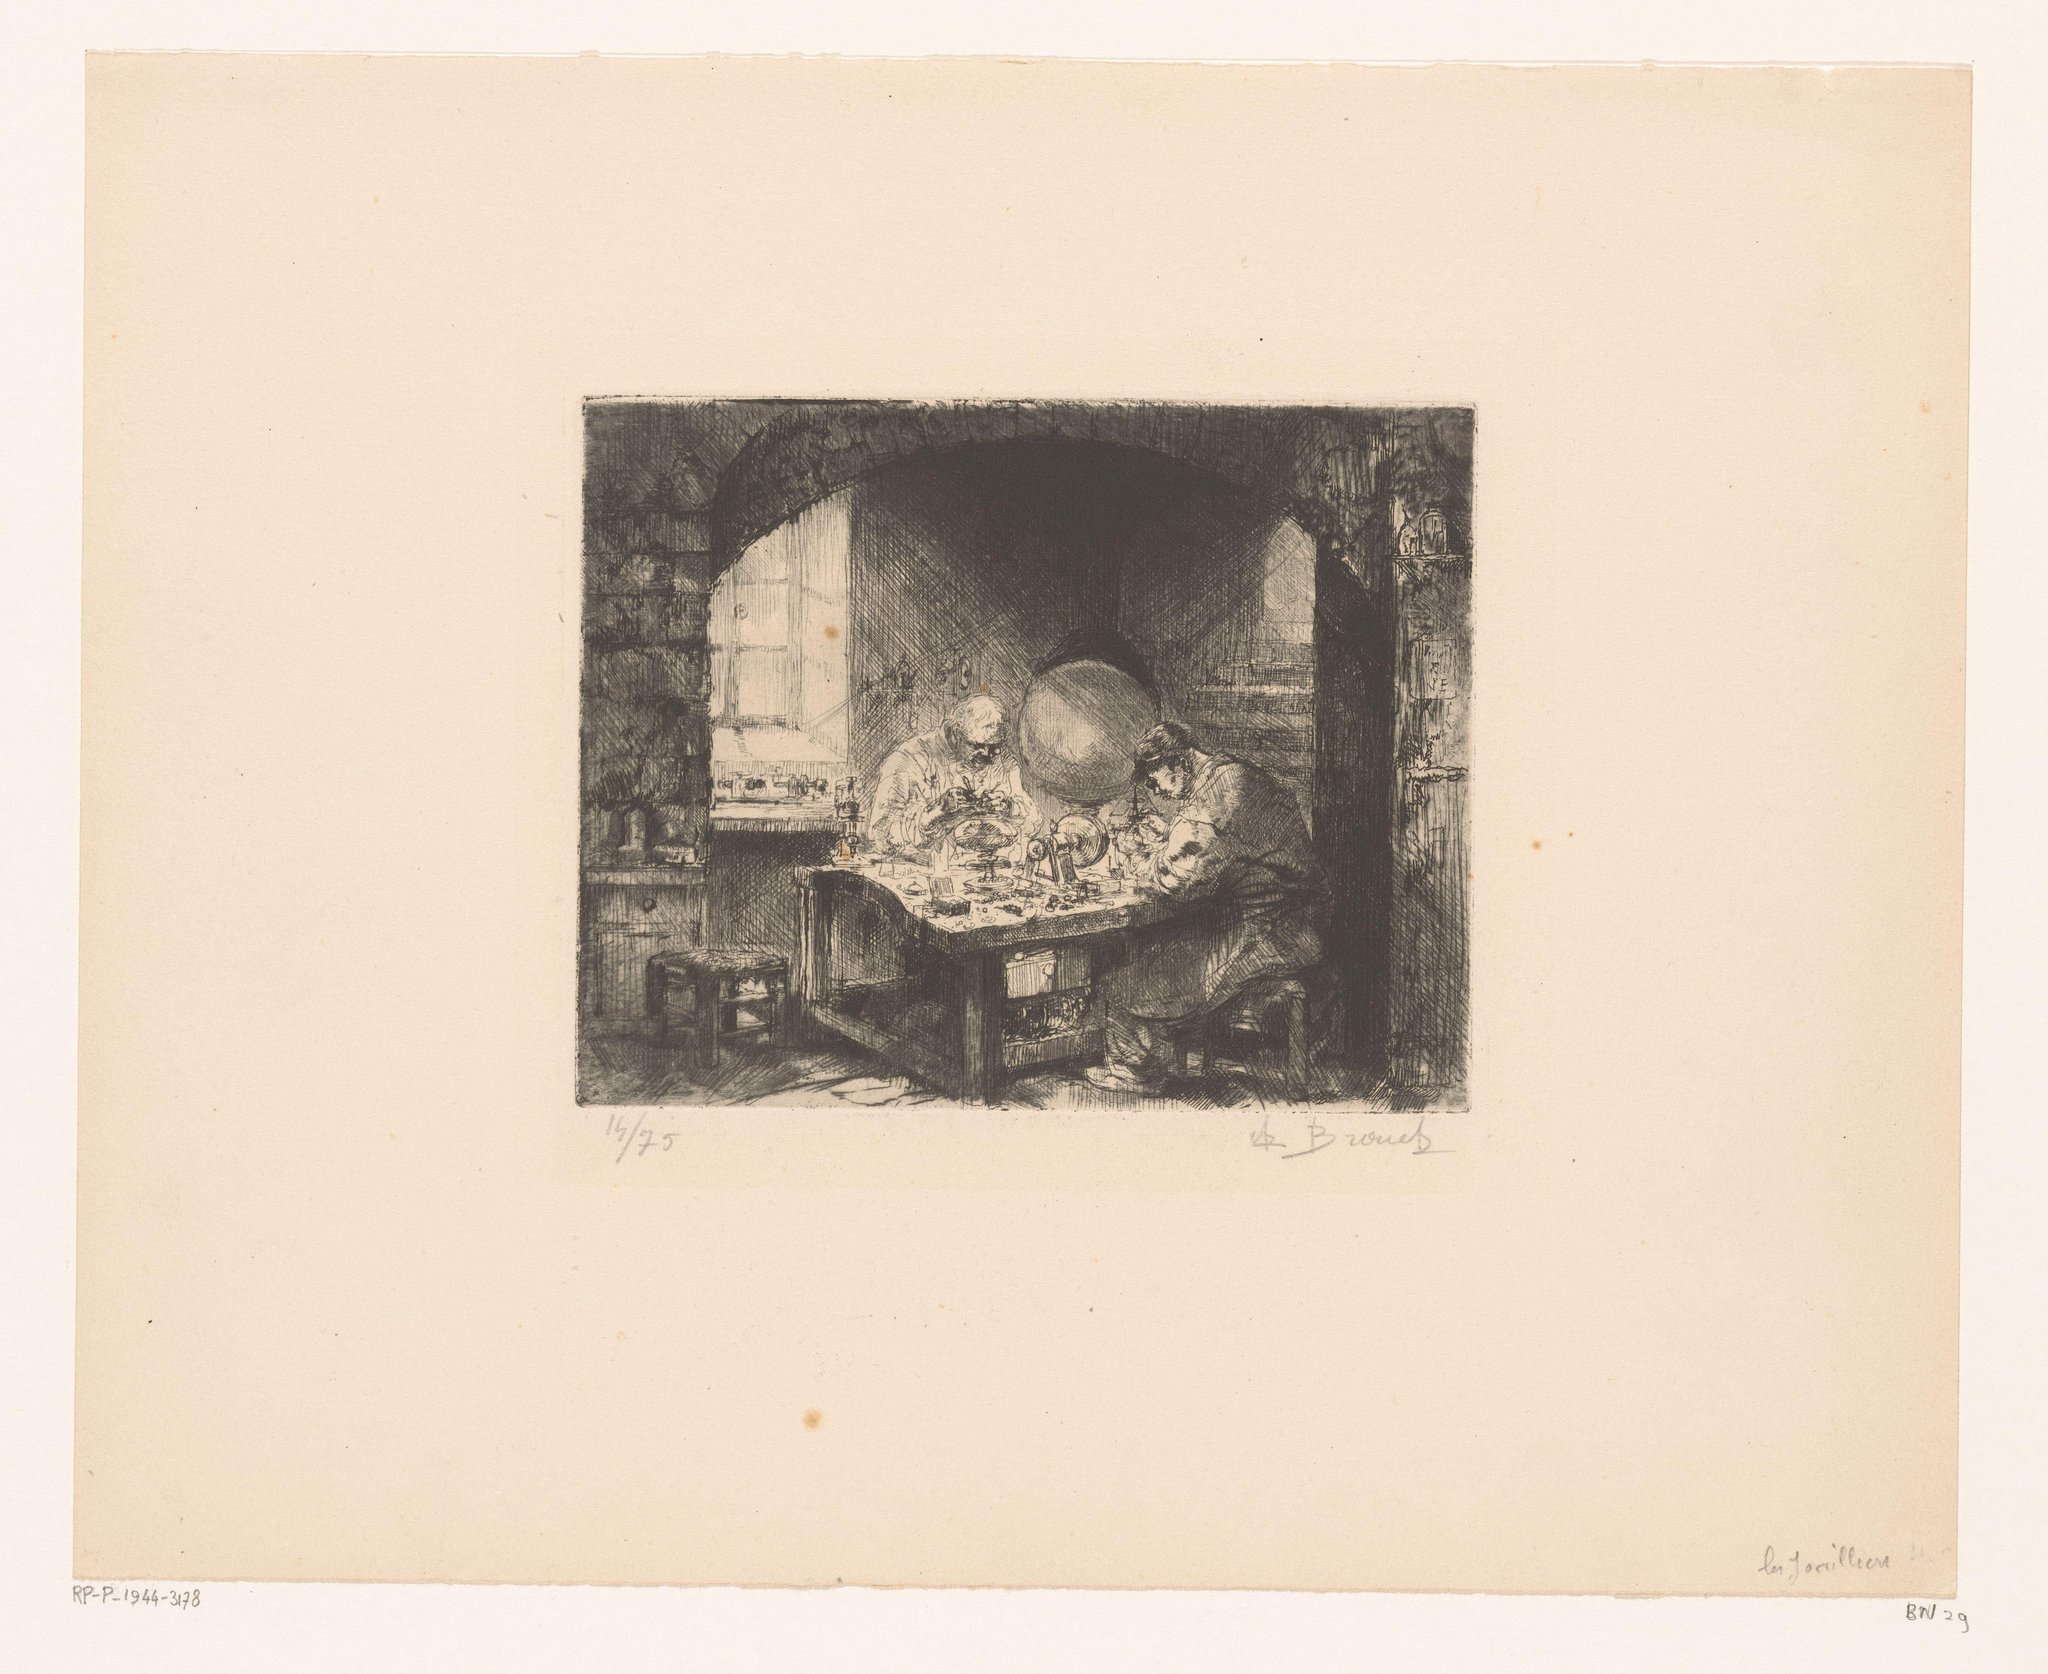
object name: print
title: Juweliers werkend in het atelier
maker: auguste brouet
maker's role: painter, print maker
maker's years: 1872-1941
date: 1882-1941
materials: paper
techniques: drypoint, etching, intaglio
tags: jeweller, goldsmith, silversmith, workshop-interior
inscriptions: collector's mark: Lugt 2228